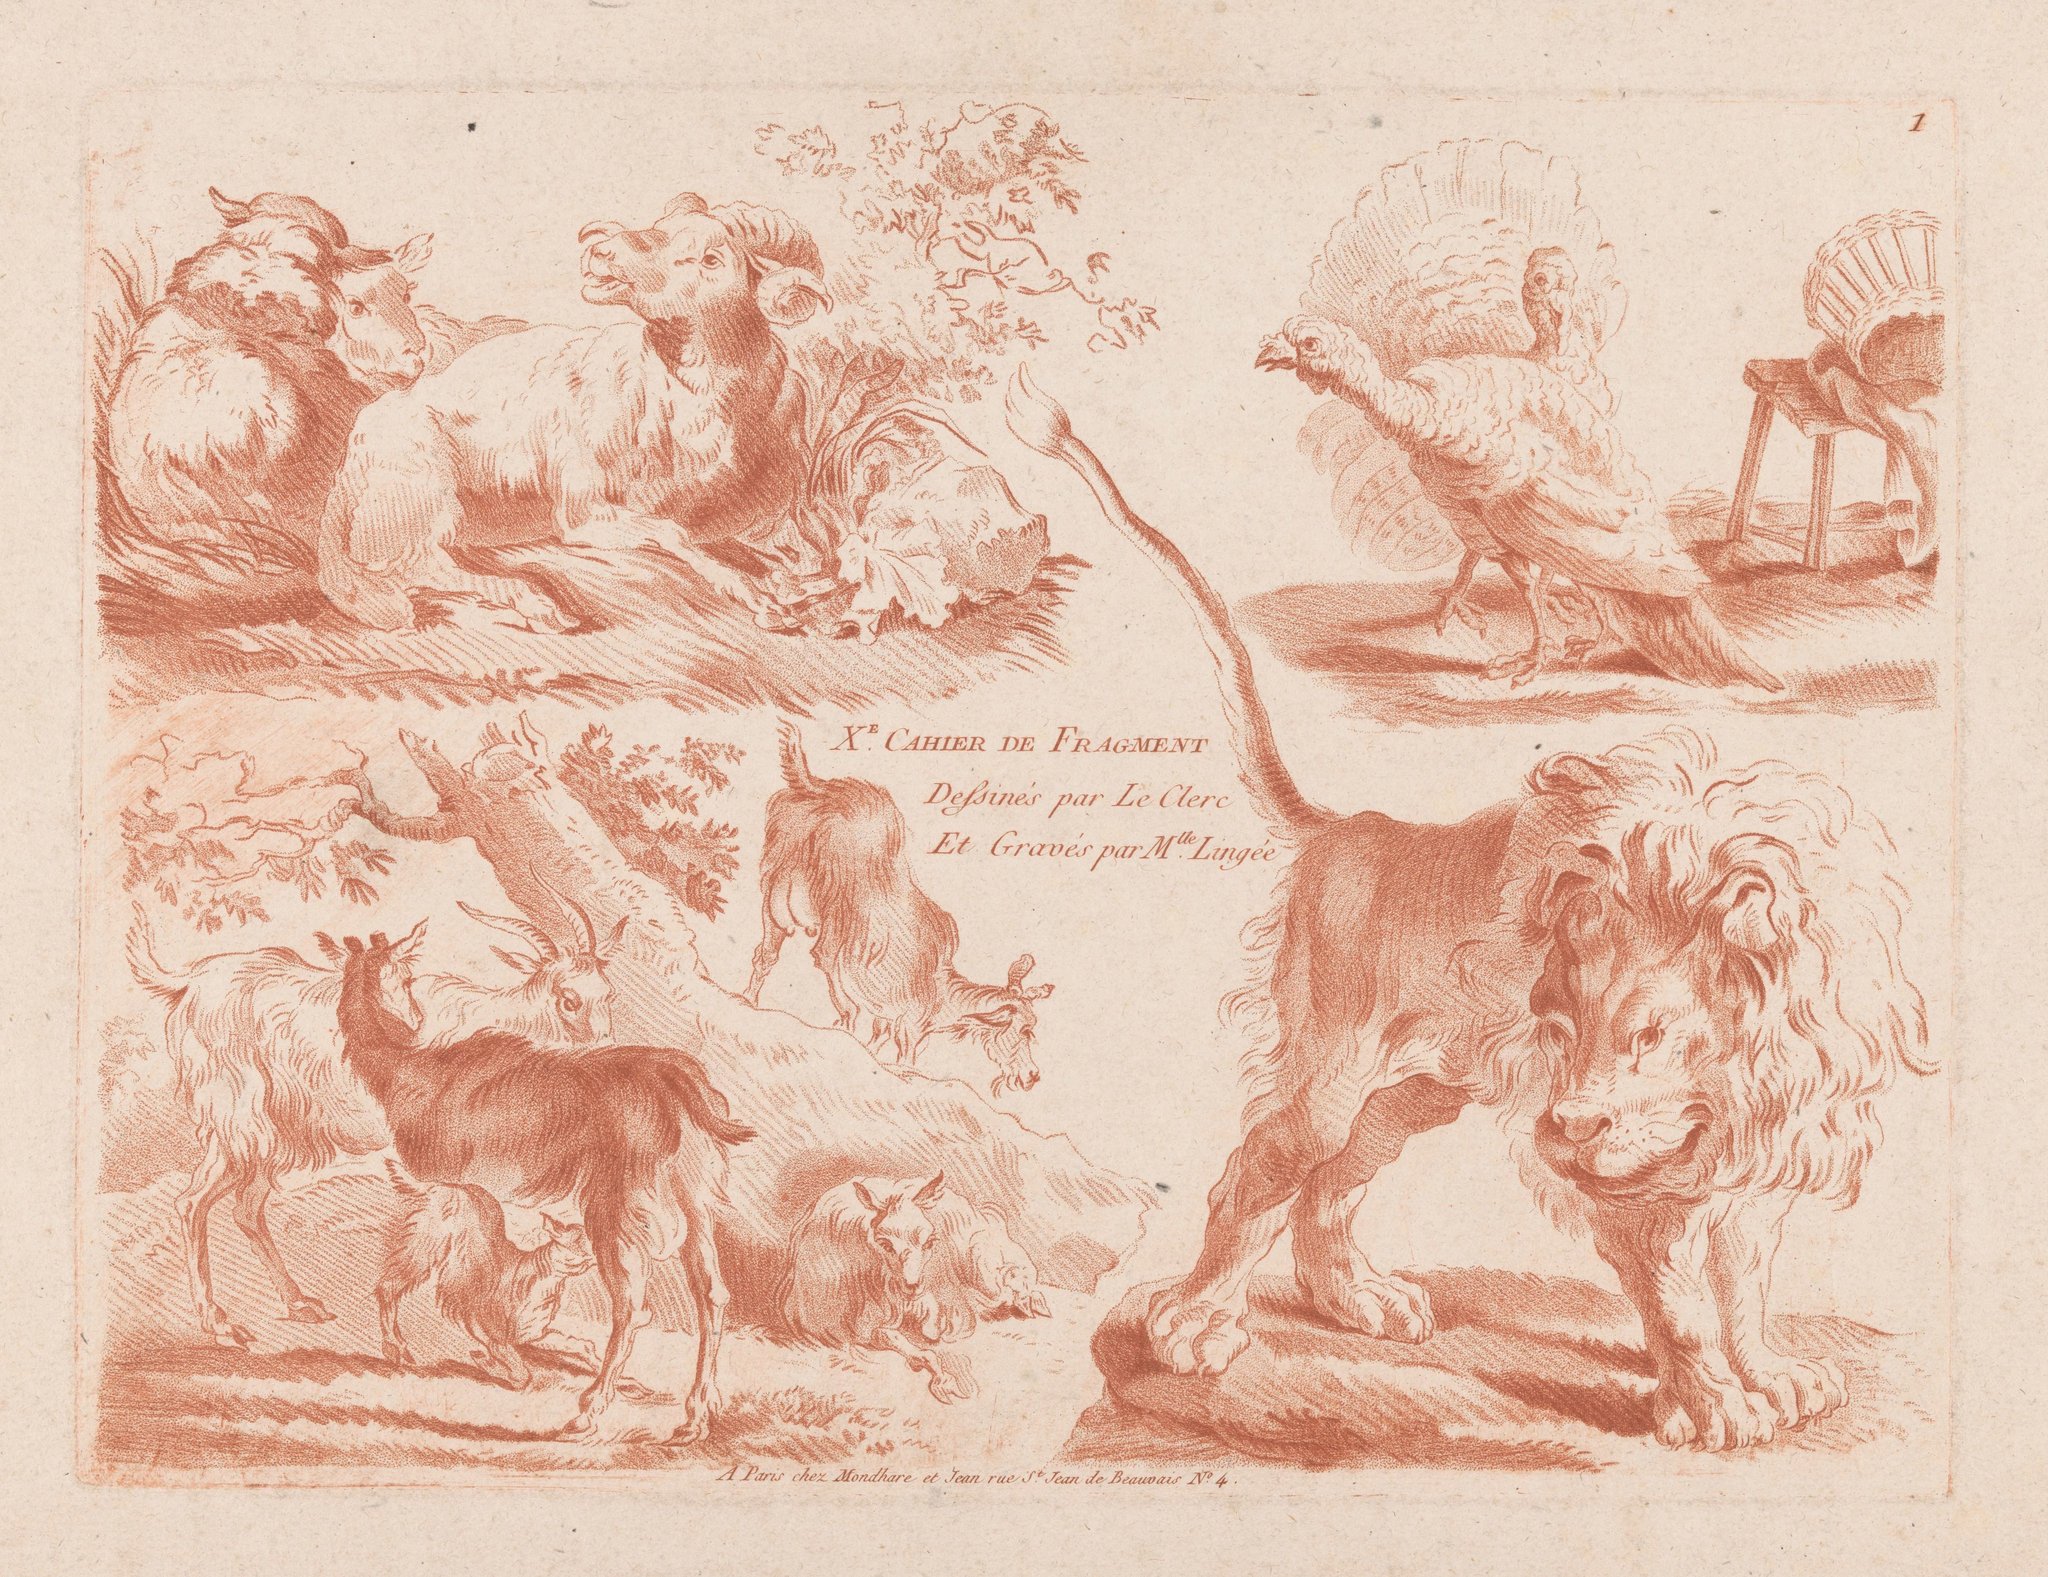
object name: print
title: Xe Cahier de Fragment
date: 1784-1796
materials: paper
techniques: printmaking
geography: paris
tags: sheep, goat, beasts of prey, predatory animals: lion, walker and runner birds: turkey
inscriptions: collector's mark: Lugt 2228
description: Vier dierstudies. Links boven liggen een ram en twee schapen. Rechts boven lopen twee pauwen naast een bankje met een omgevallen mand. Links onder bevinden zich een bok en drie geiten bij een boom, één geit zoogt een lam. Rechts onder staat een leeuw.